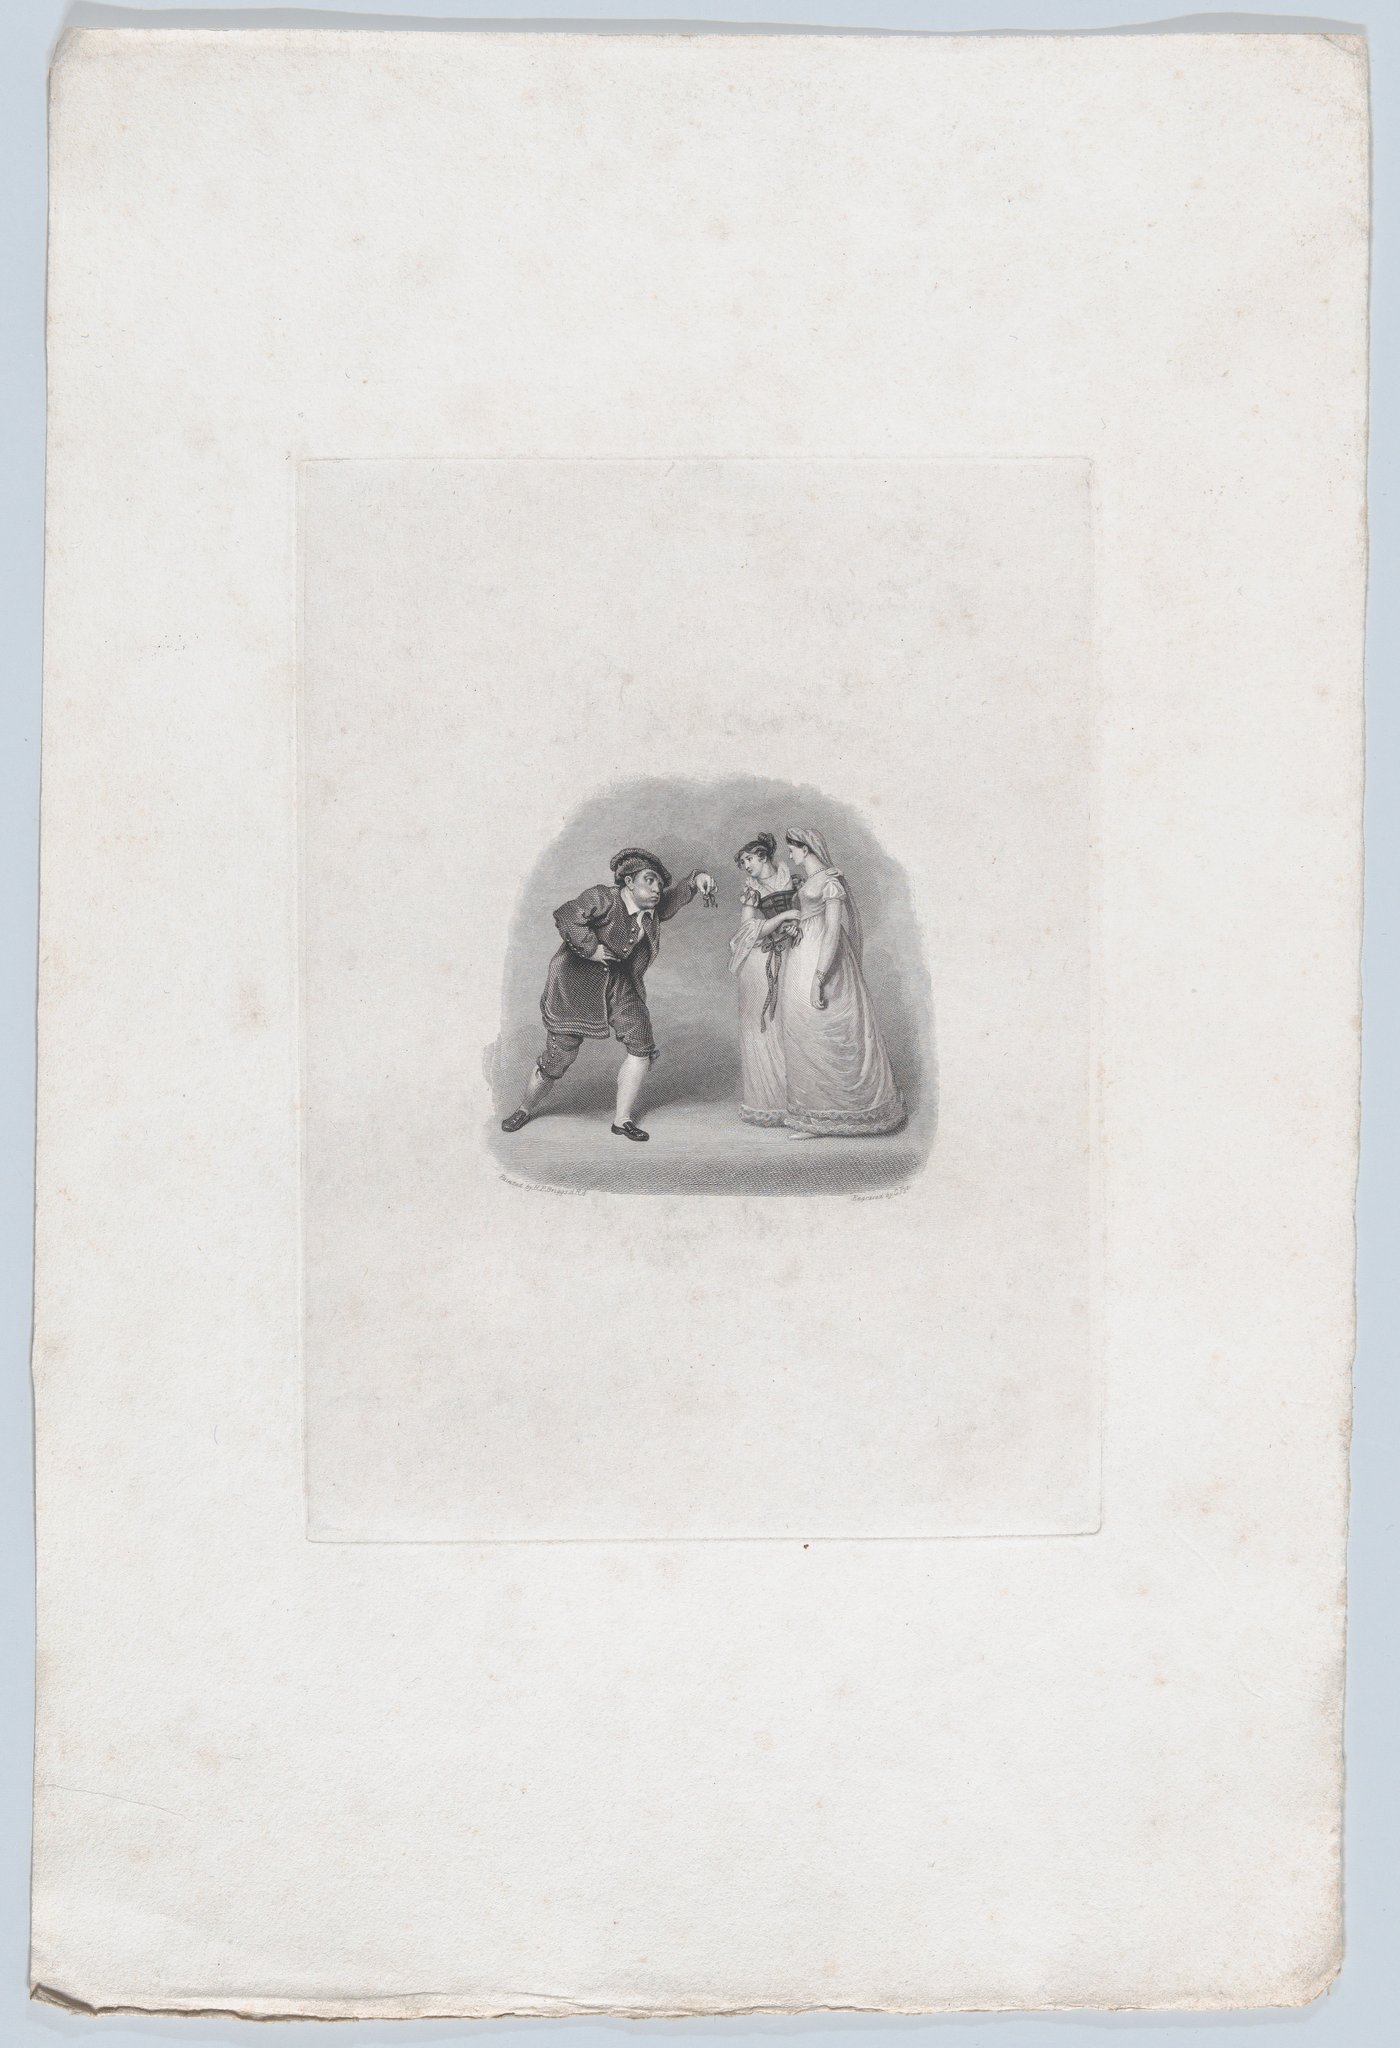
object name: print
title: Dromio, Adriana and Luciana (Shakespeare, Comedy of Errors, Act 4, Scene 2)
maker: charles pye jr.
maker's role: engraver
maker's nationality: british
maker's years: 1777-1864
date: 1827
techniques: printmaking, engraving, etching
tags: shakespeare,men,women